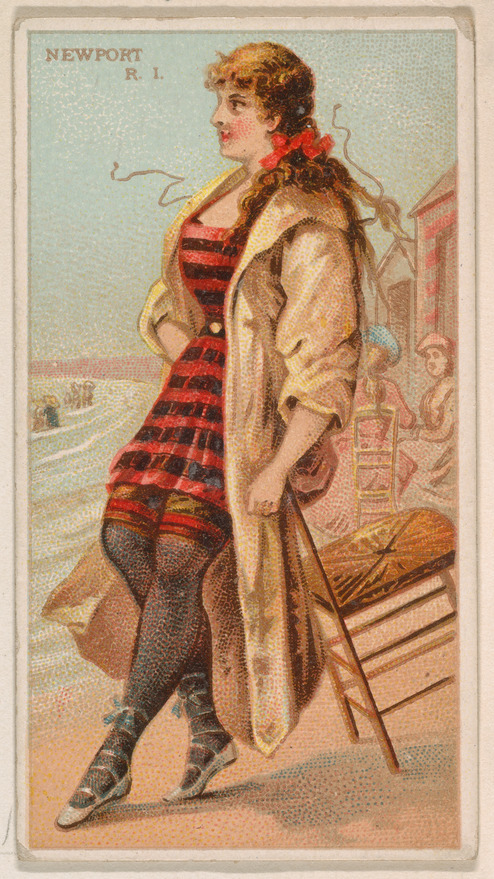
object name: print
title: Newport, Rhode Island, from the Surf Beauties series (N232), issued by Kinney Bros.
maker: kinney brothers tobacco company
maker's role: publisher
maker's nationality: american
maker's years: 1869-2011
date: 1889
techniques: color lithograph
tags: profiles,women,sports,athletes